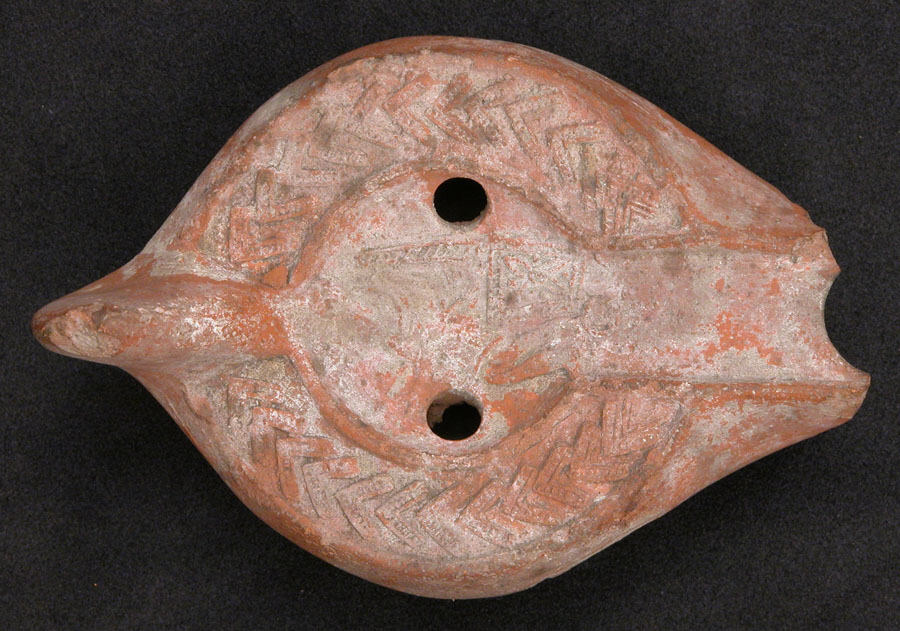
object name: lamp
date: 401-600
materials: earthenware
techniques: molding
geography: egypt